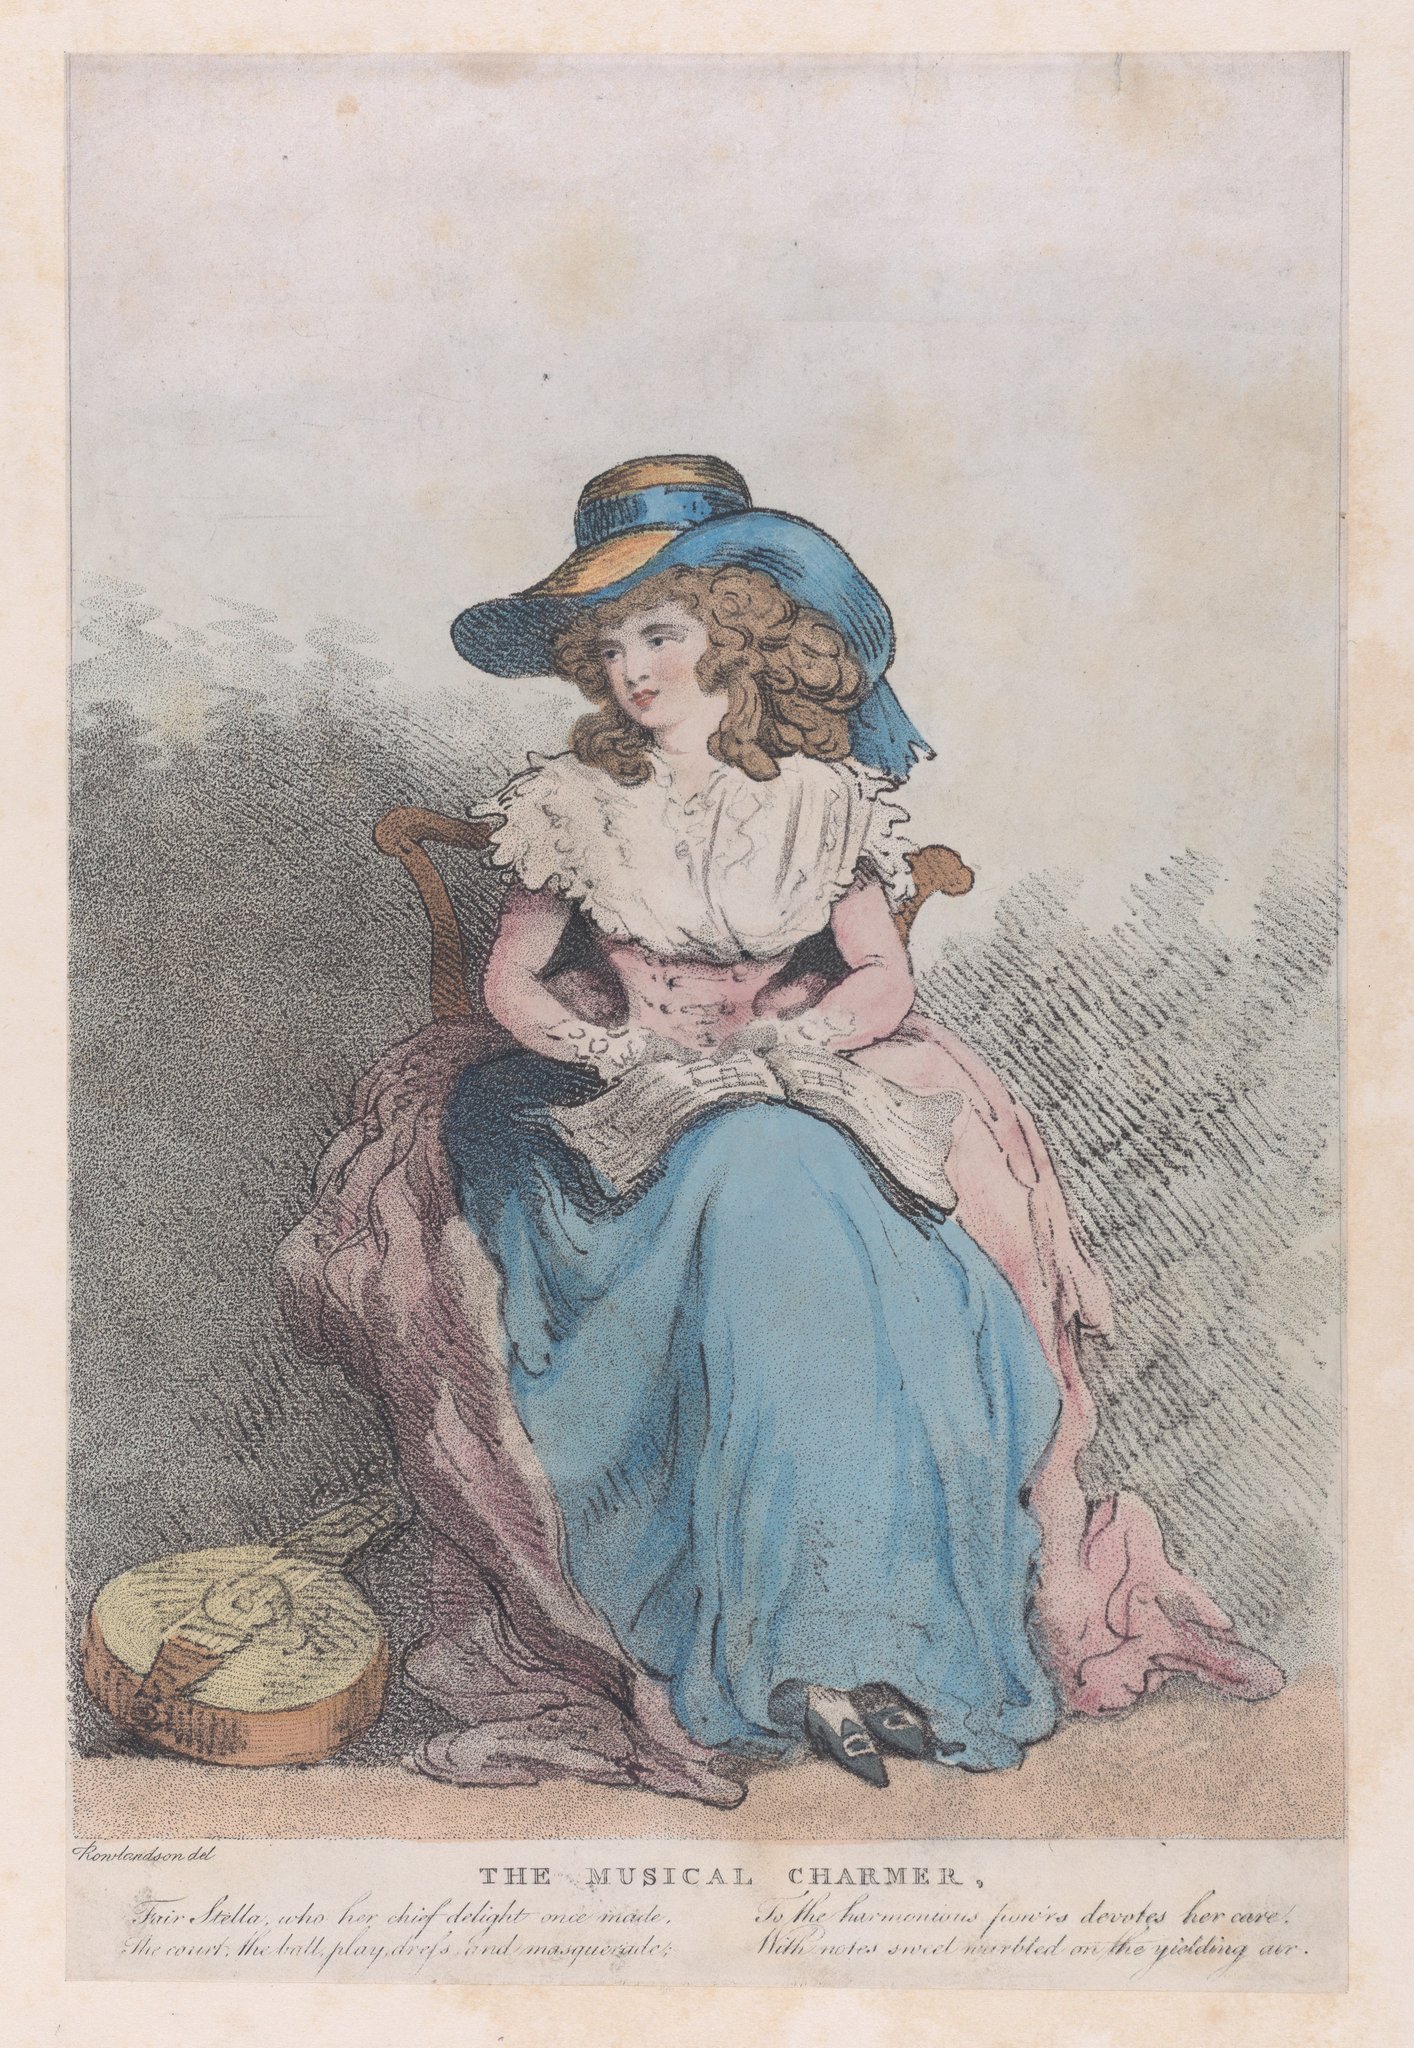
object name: print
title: The Musical Charmer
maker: thomas rowlandson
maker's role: artist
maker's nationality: british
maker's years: 1757-1827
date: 1793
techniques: hand coloring, roulette, etching, stippling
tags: musical instruments,women,music